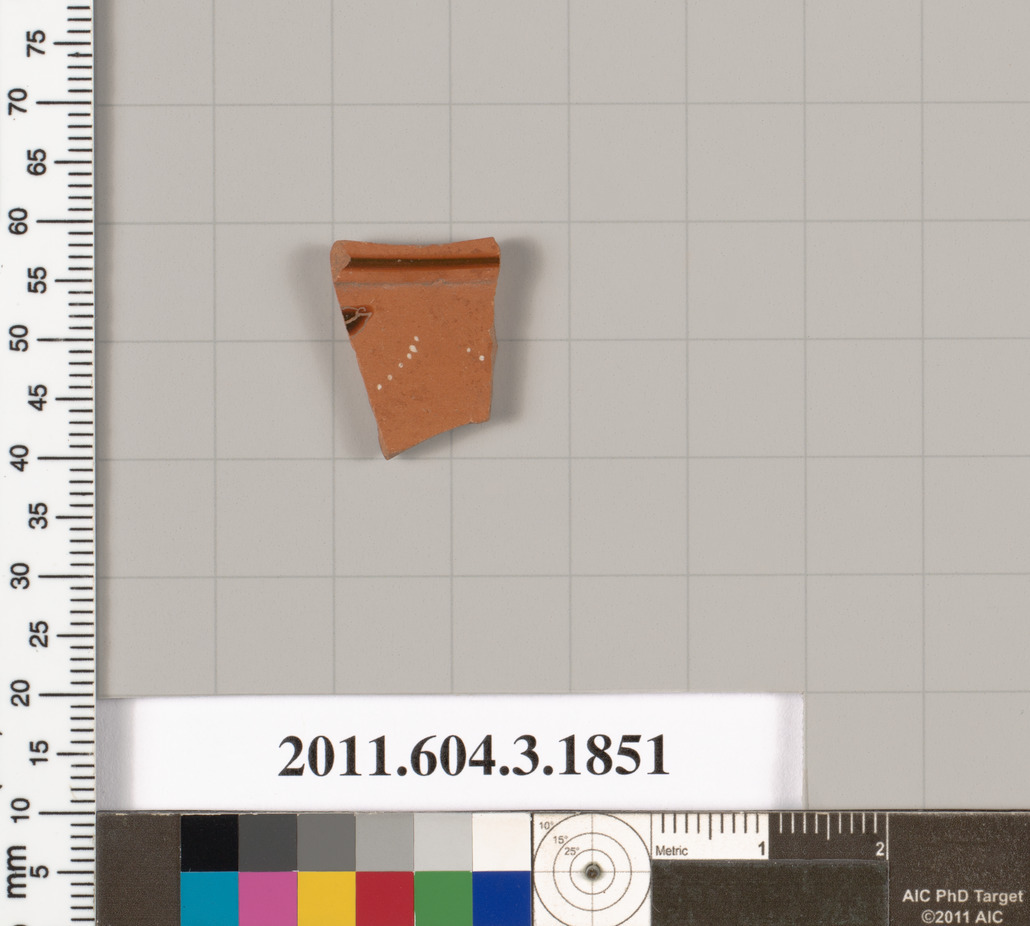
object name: kylix fragment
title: Terracotta fragment of a kylix: Lip cup (drinking cup)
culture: greek, attic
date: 567-535 BCE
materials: terracotta